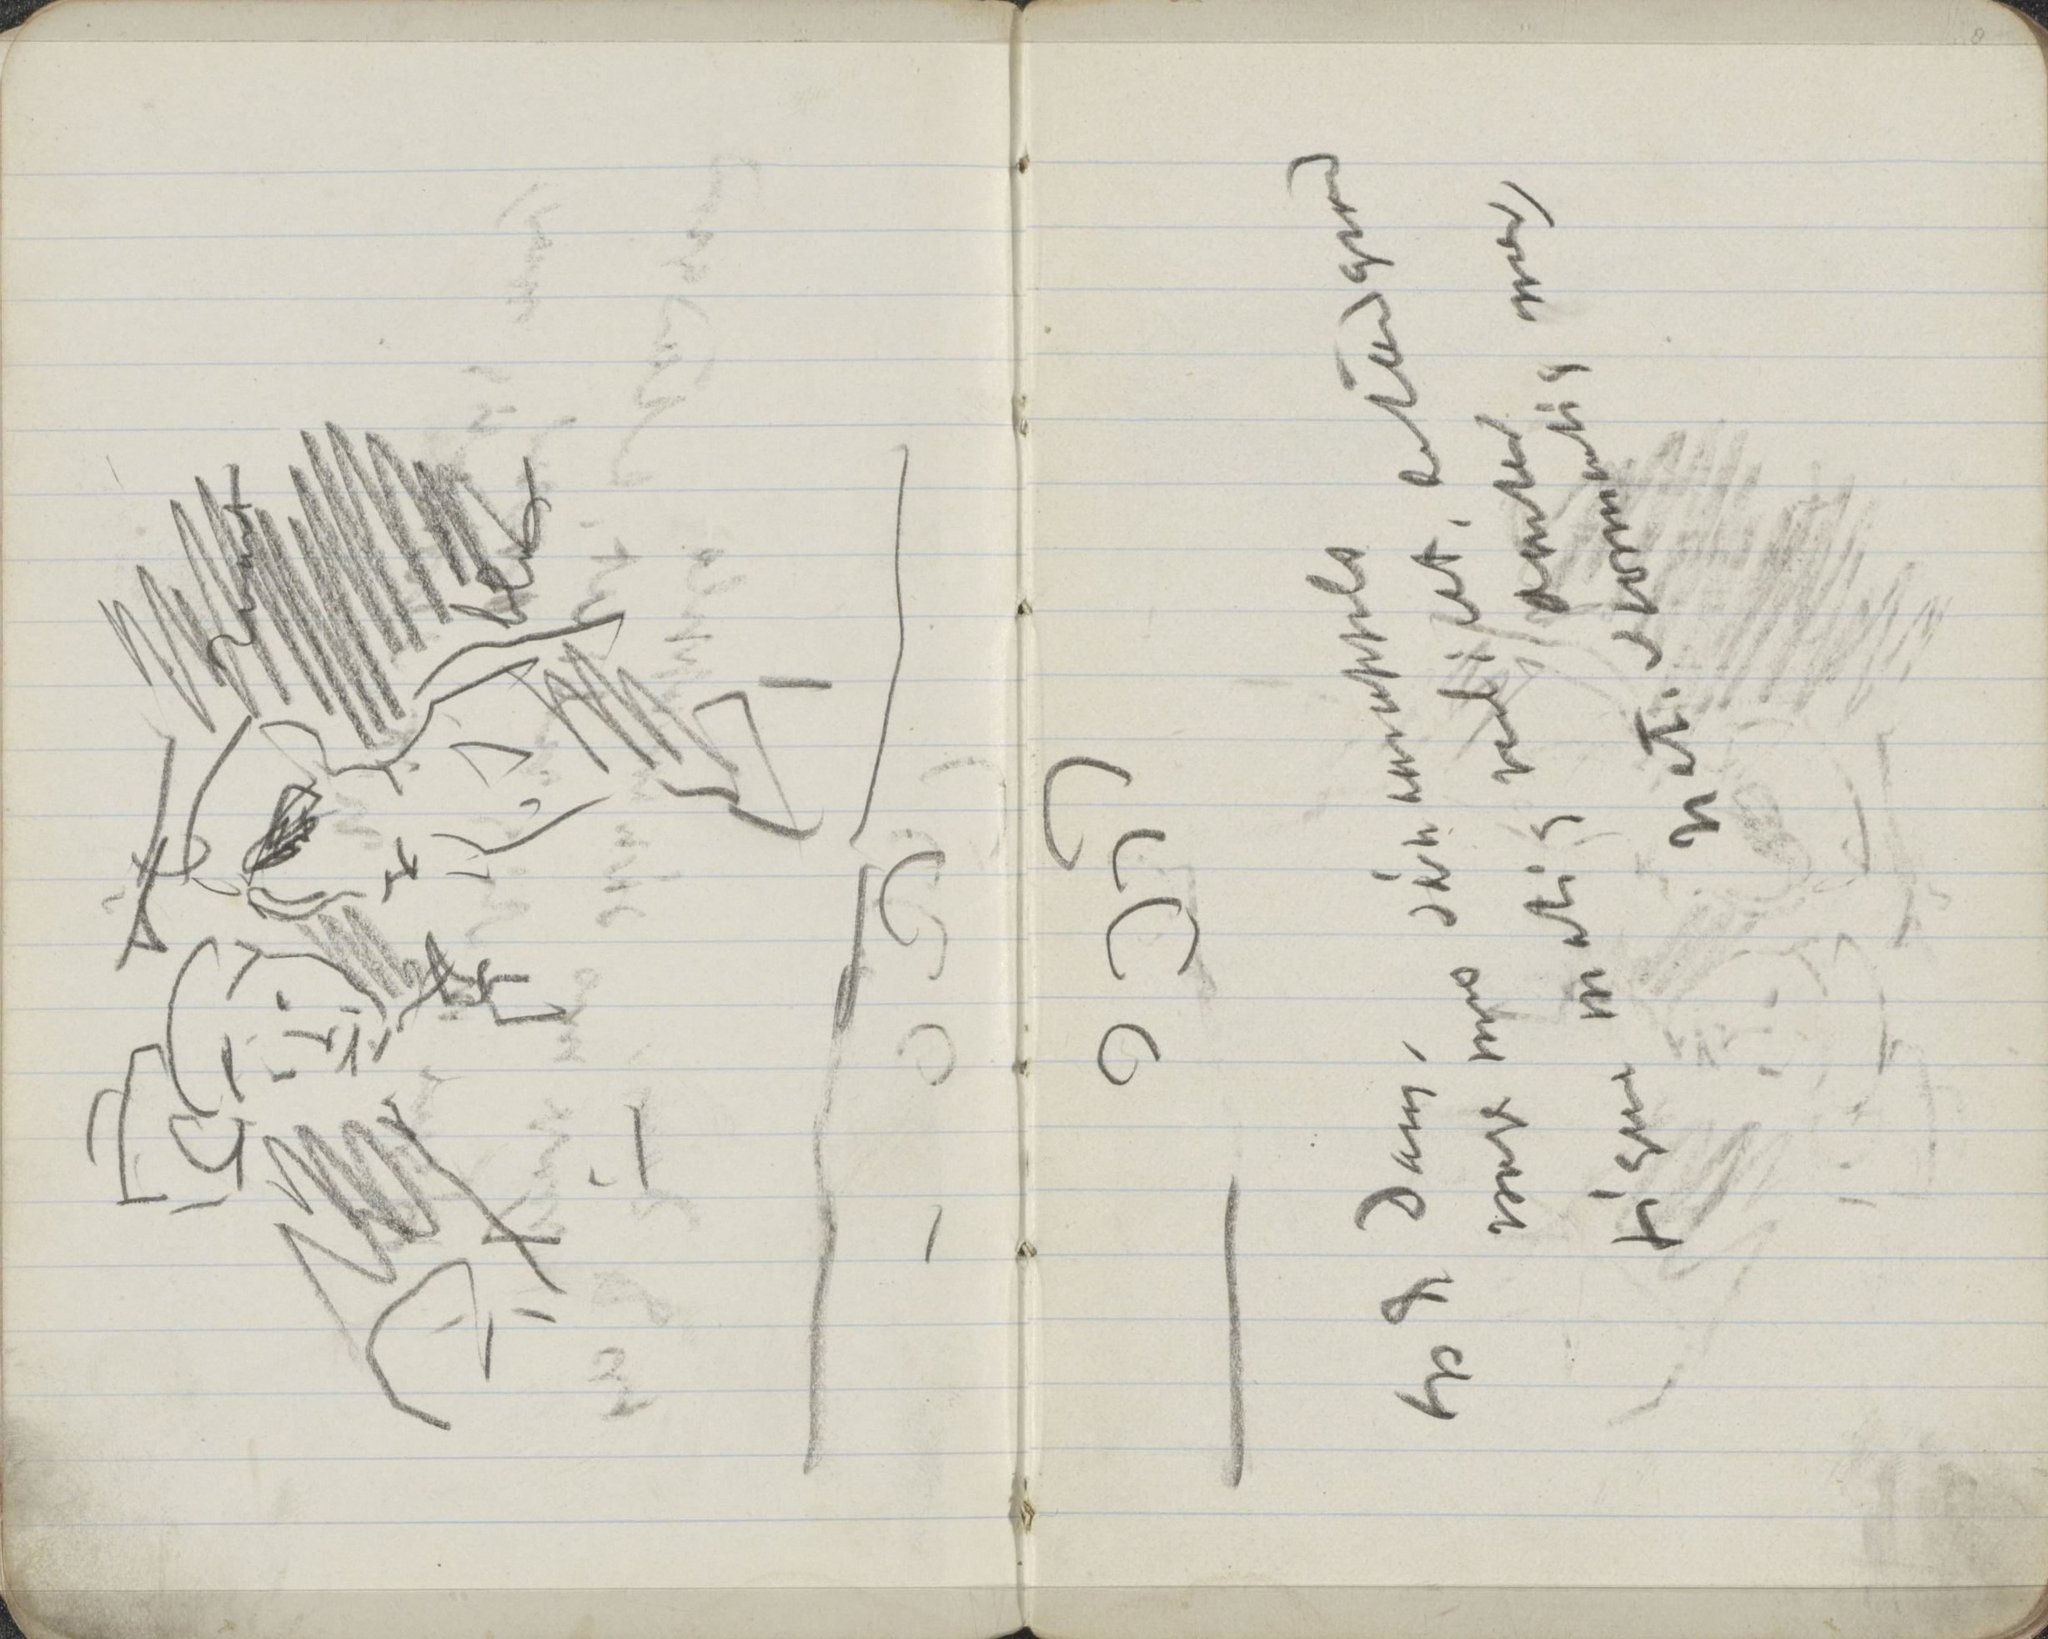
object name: sketchbook leaf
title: Vrouwen bij een kraam met sinaasappels op de Dam te Amsterdam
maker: george hendrik breitner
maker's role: draughtsman, painter, print maker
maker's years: 1857-1923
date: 1893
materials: chalk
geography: amsterdam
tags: stall, booth (~ market), adult woman (+ two persons), fruits: orange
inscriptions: annotation: ‘Op de Dam,/[...] sinaasappels/ figuur matig verlicht, achtergrond/ donker/ [...]’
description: Pagina 7 en pagina 8 uit een schetsboek met 38 bladen.